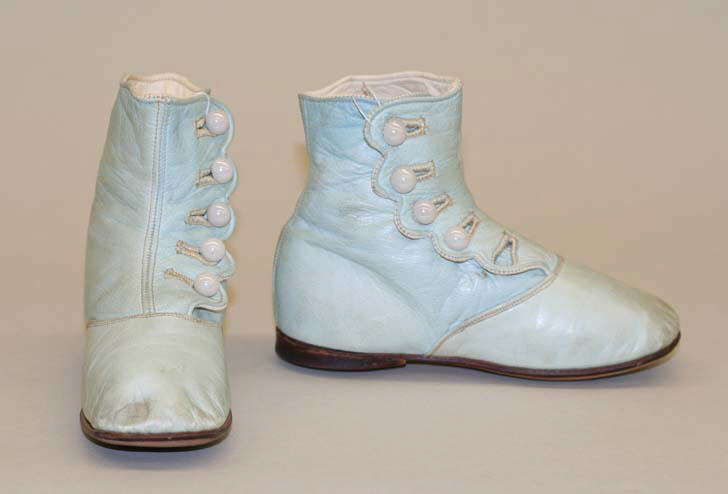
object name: shoe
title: Shoes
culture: american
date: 1895-1899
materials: leather